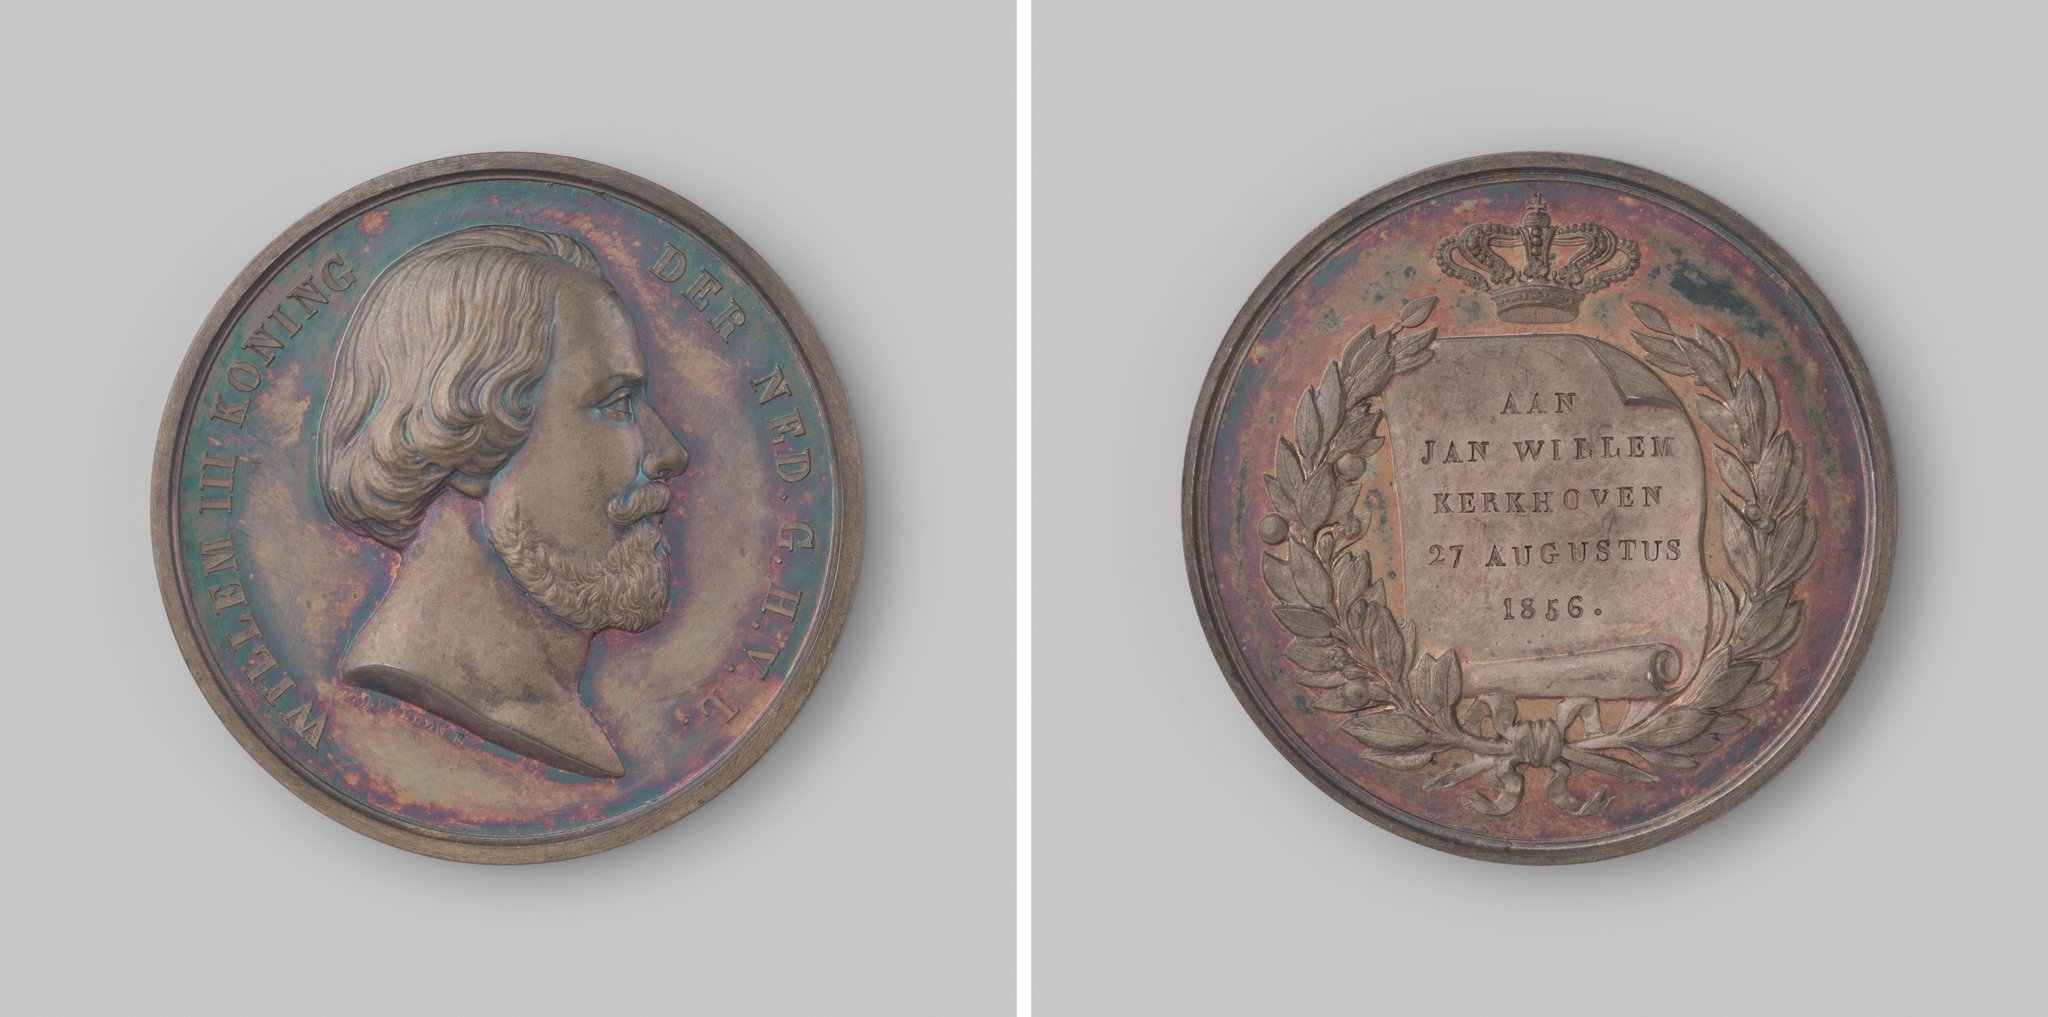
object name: history medal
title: Erepenning door koning Willem III geschonken aan Jan Willem Kerkhoven, oud-luitenant-kolonel der Schutterij te Amsterdam, ter gelegenheid van de onthulling van het Monument op de Dam te Amsterdam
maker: david van der kellen (1804-1879)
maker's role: die cutter, draughtsman, print maker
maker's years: 1804-1879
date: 1856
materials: silver